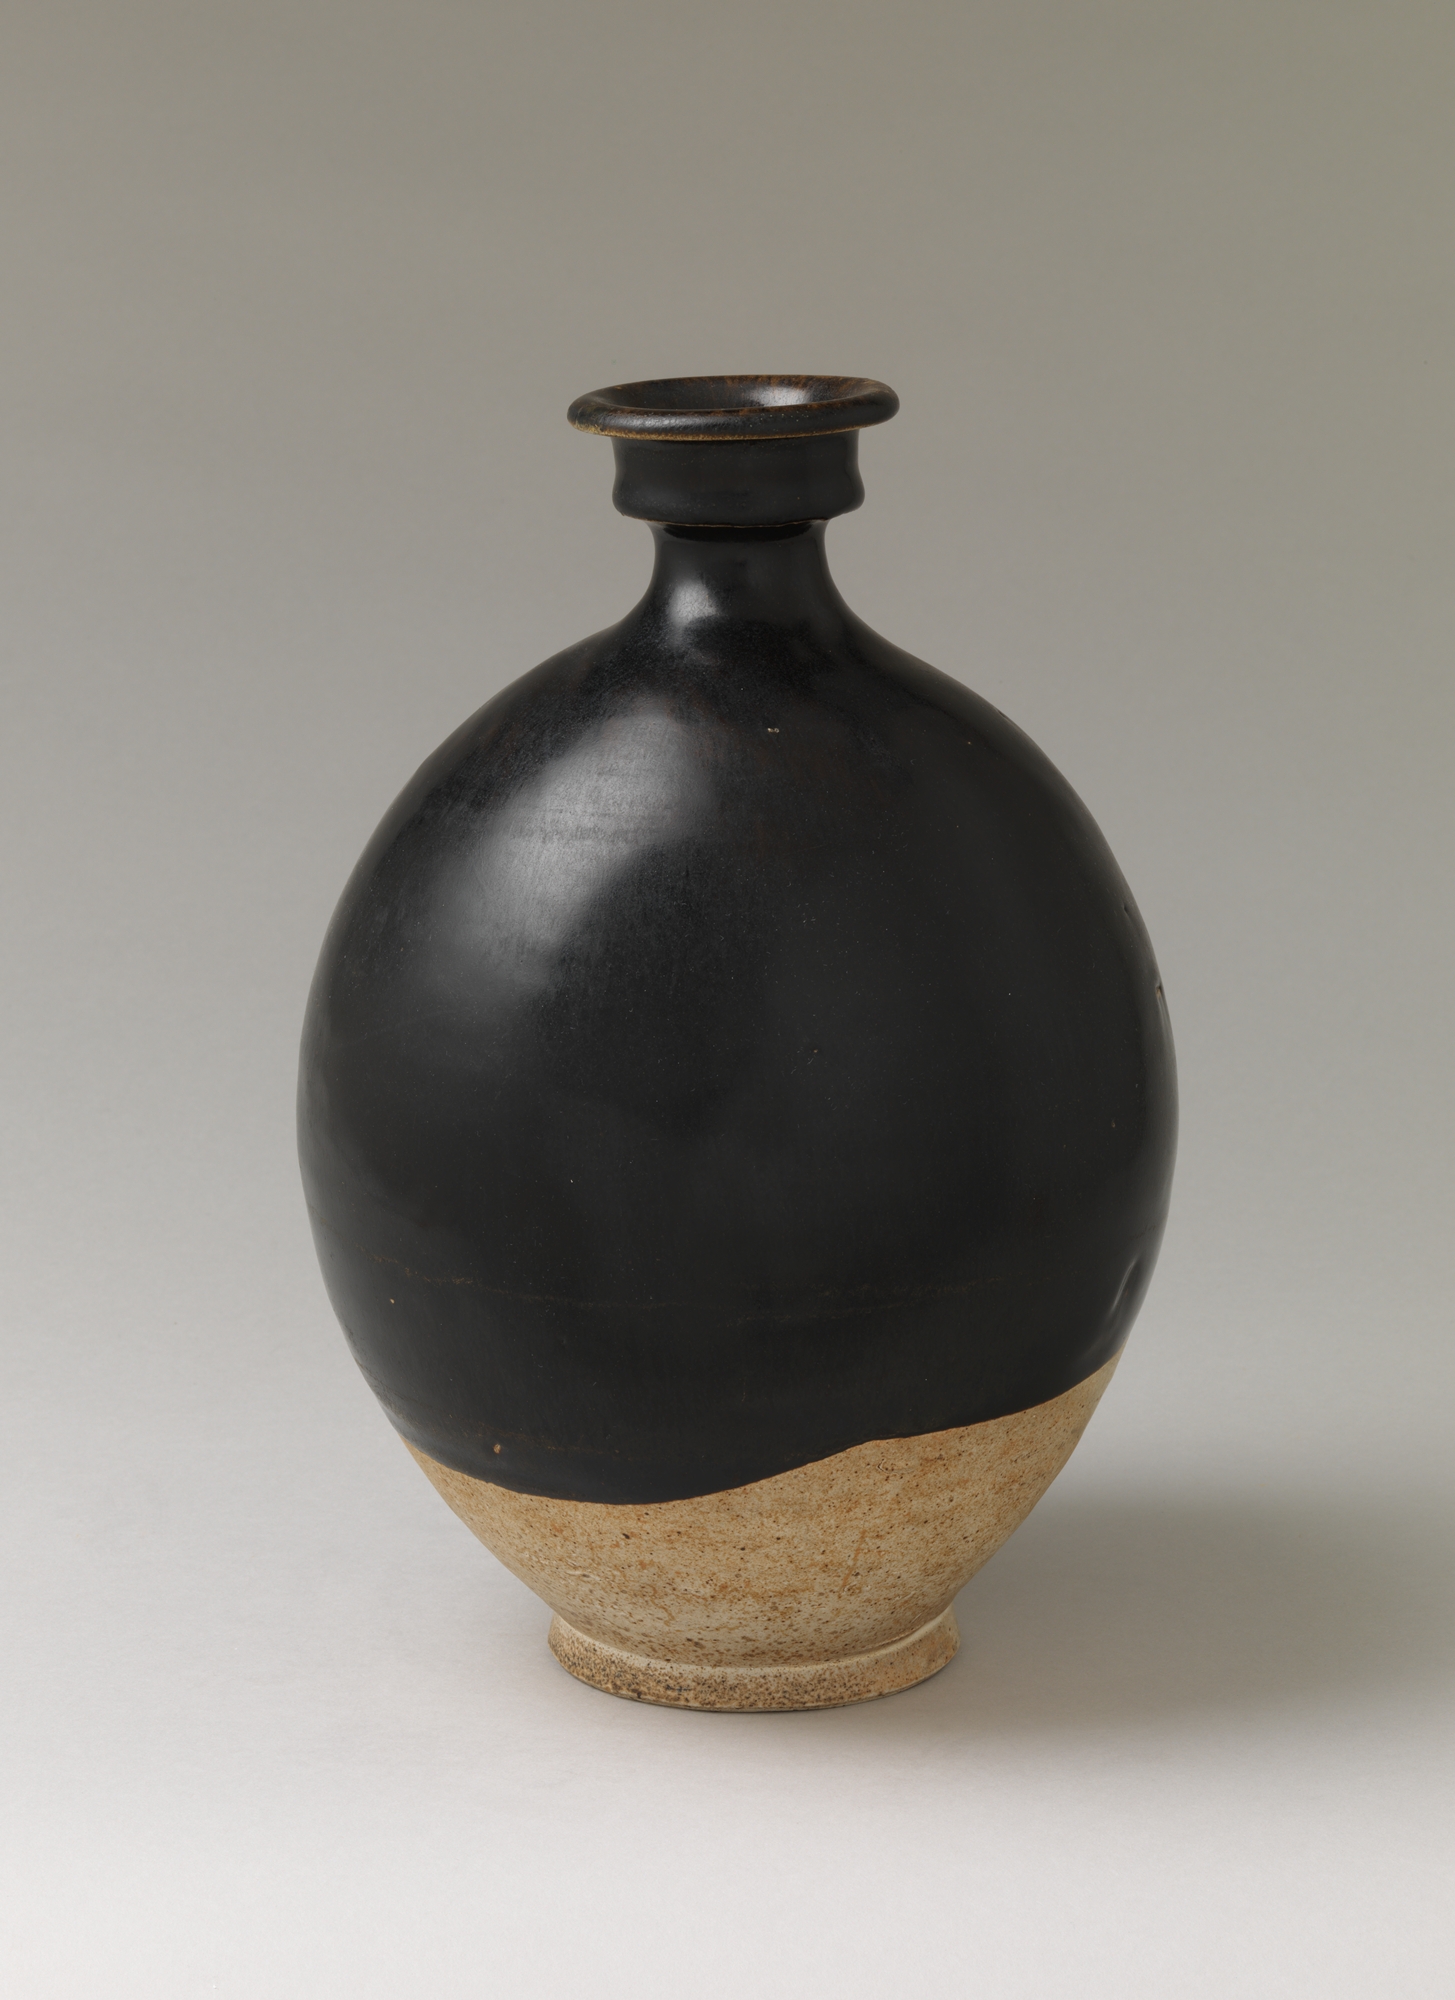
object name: vase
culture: chinese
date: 701-800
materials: earthenware, glaze